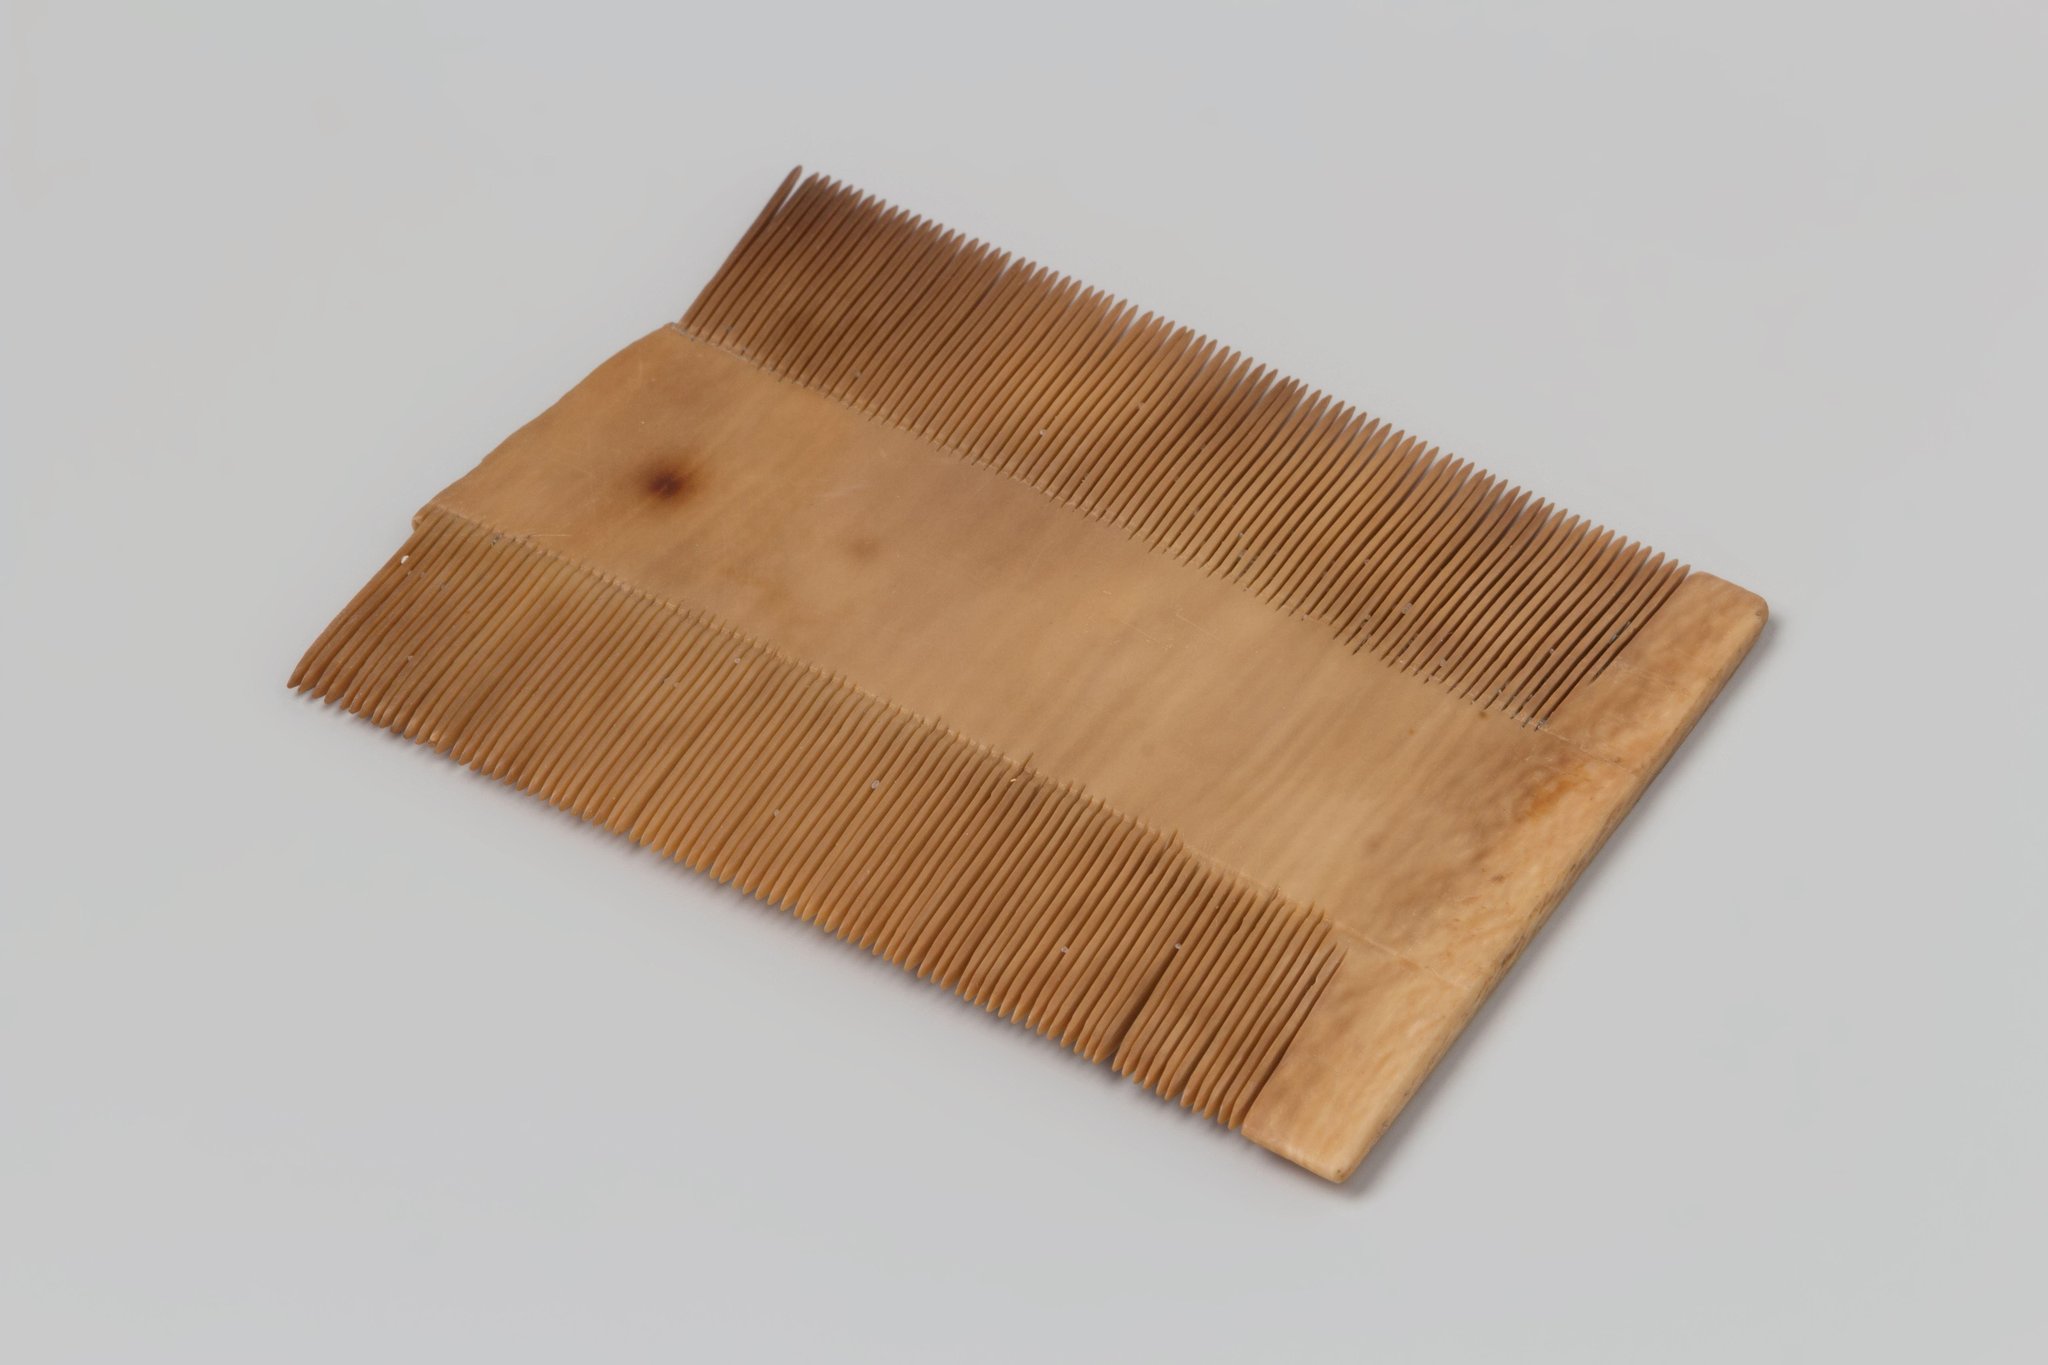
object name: louse comb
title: Luizenkam uit het wrak van de Oost-Indiëvaarder 't Vliegend Hart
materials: bone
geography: middelburg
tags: 't vliegend hart (schip), verenigde oostindische compagnie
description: Benen kam, rechthoekig, tweezijdig met zeer fijne betanding. Eén zijkant ontbreekt. Verder zeer gaaf, lichtbruin van kleur. Lice comb.